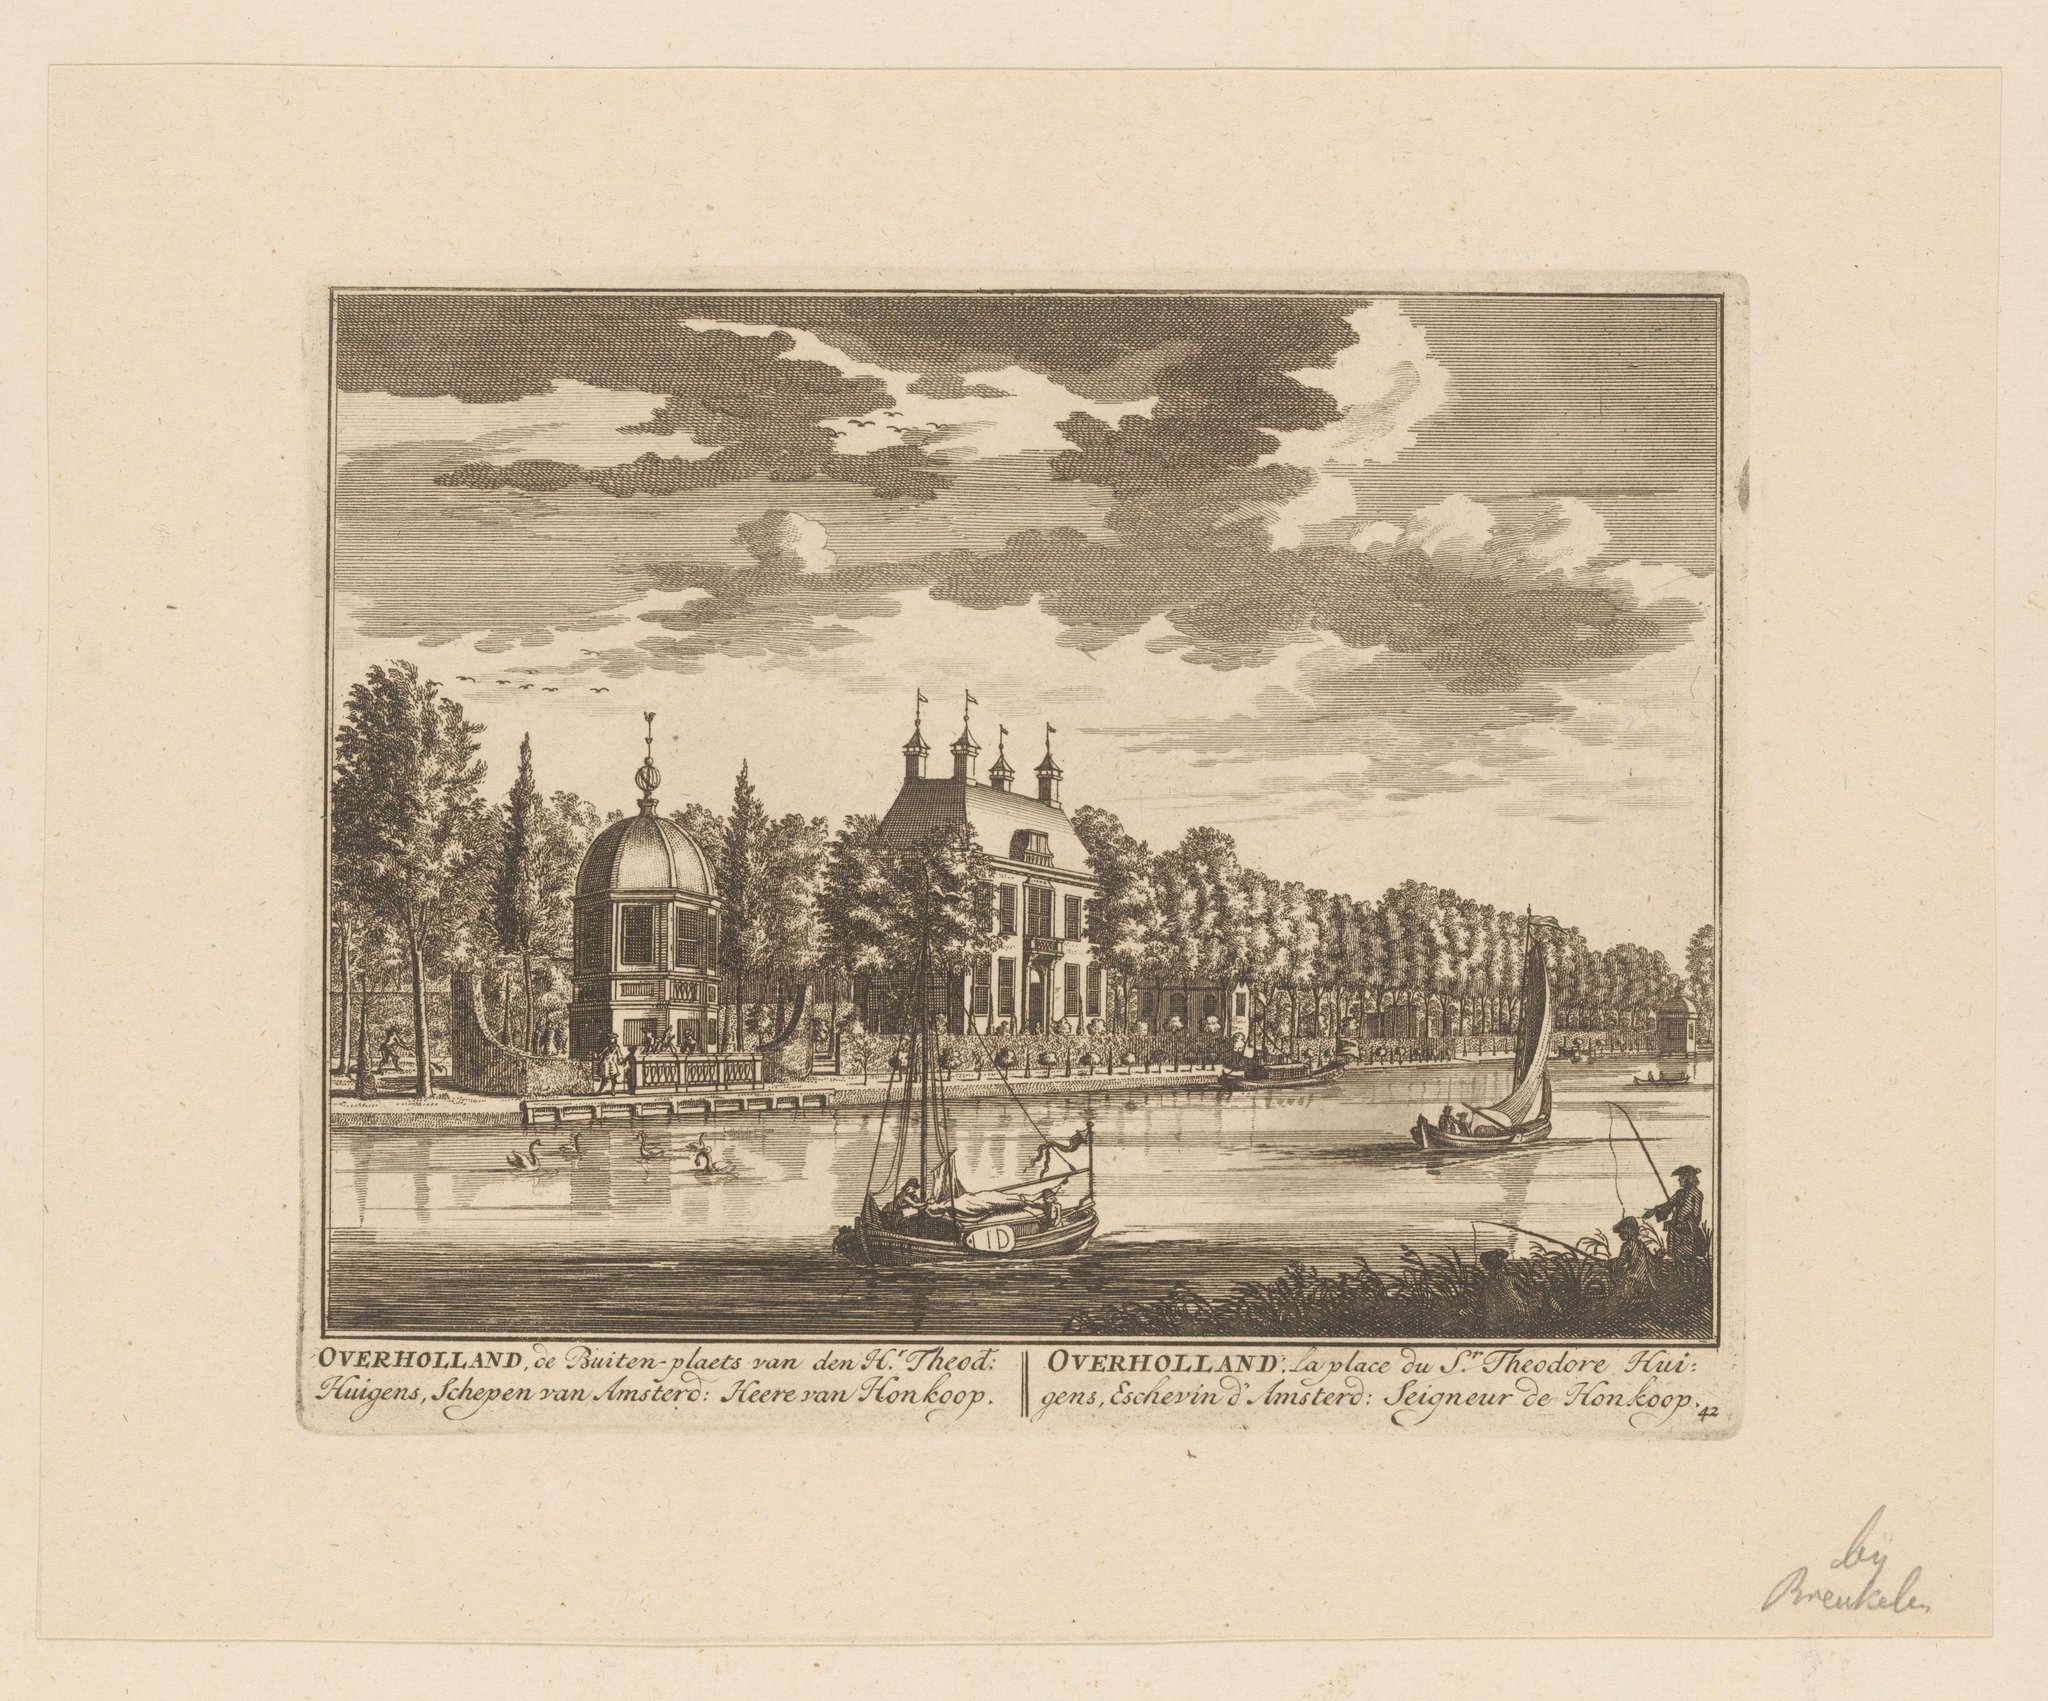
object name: book illustration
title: Gezicht op buitenplaats Overholland bij Breukelen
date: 1719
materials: paper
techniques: etching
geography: amsterdam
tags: rural housing, e.g. country-house, villa, cottage, landscape with tower or castle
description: Prent uit: Stopendaal, Daniël. De zegepraalende Vecht, vertoonende verscheidenen gesichten van lustplaatsen, heeren huysen en dorpen, beginnende van Uitrecht en met Muyden besluytende. Amsterdam: Weduwe Nicolaas Visscher, 1719.